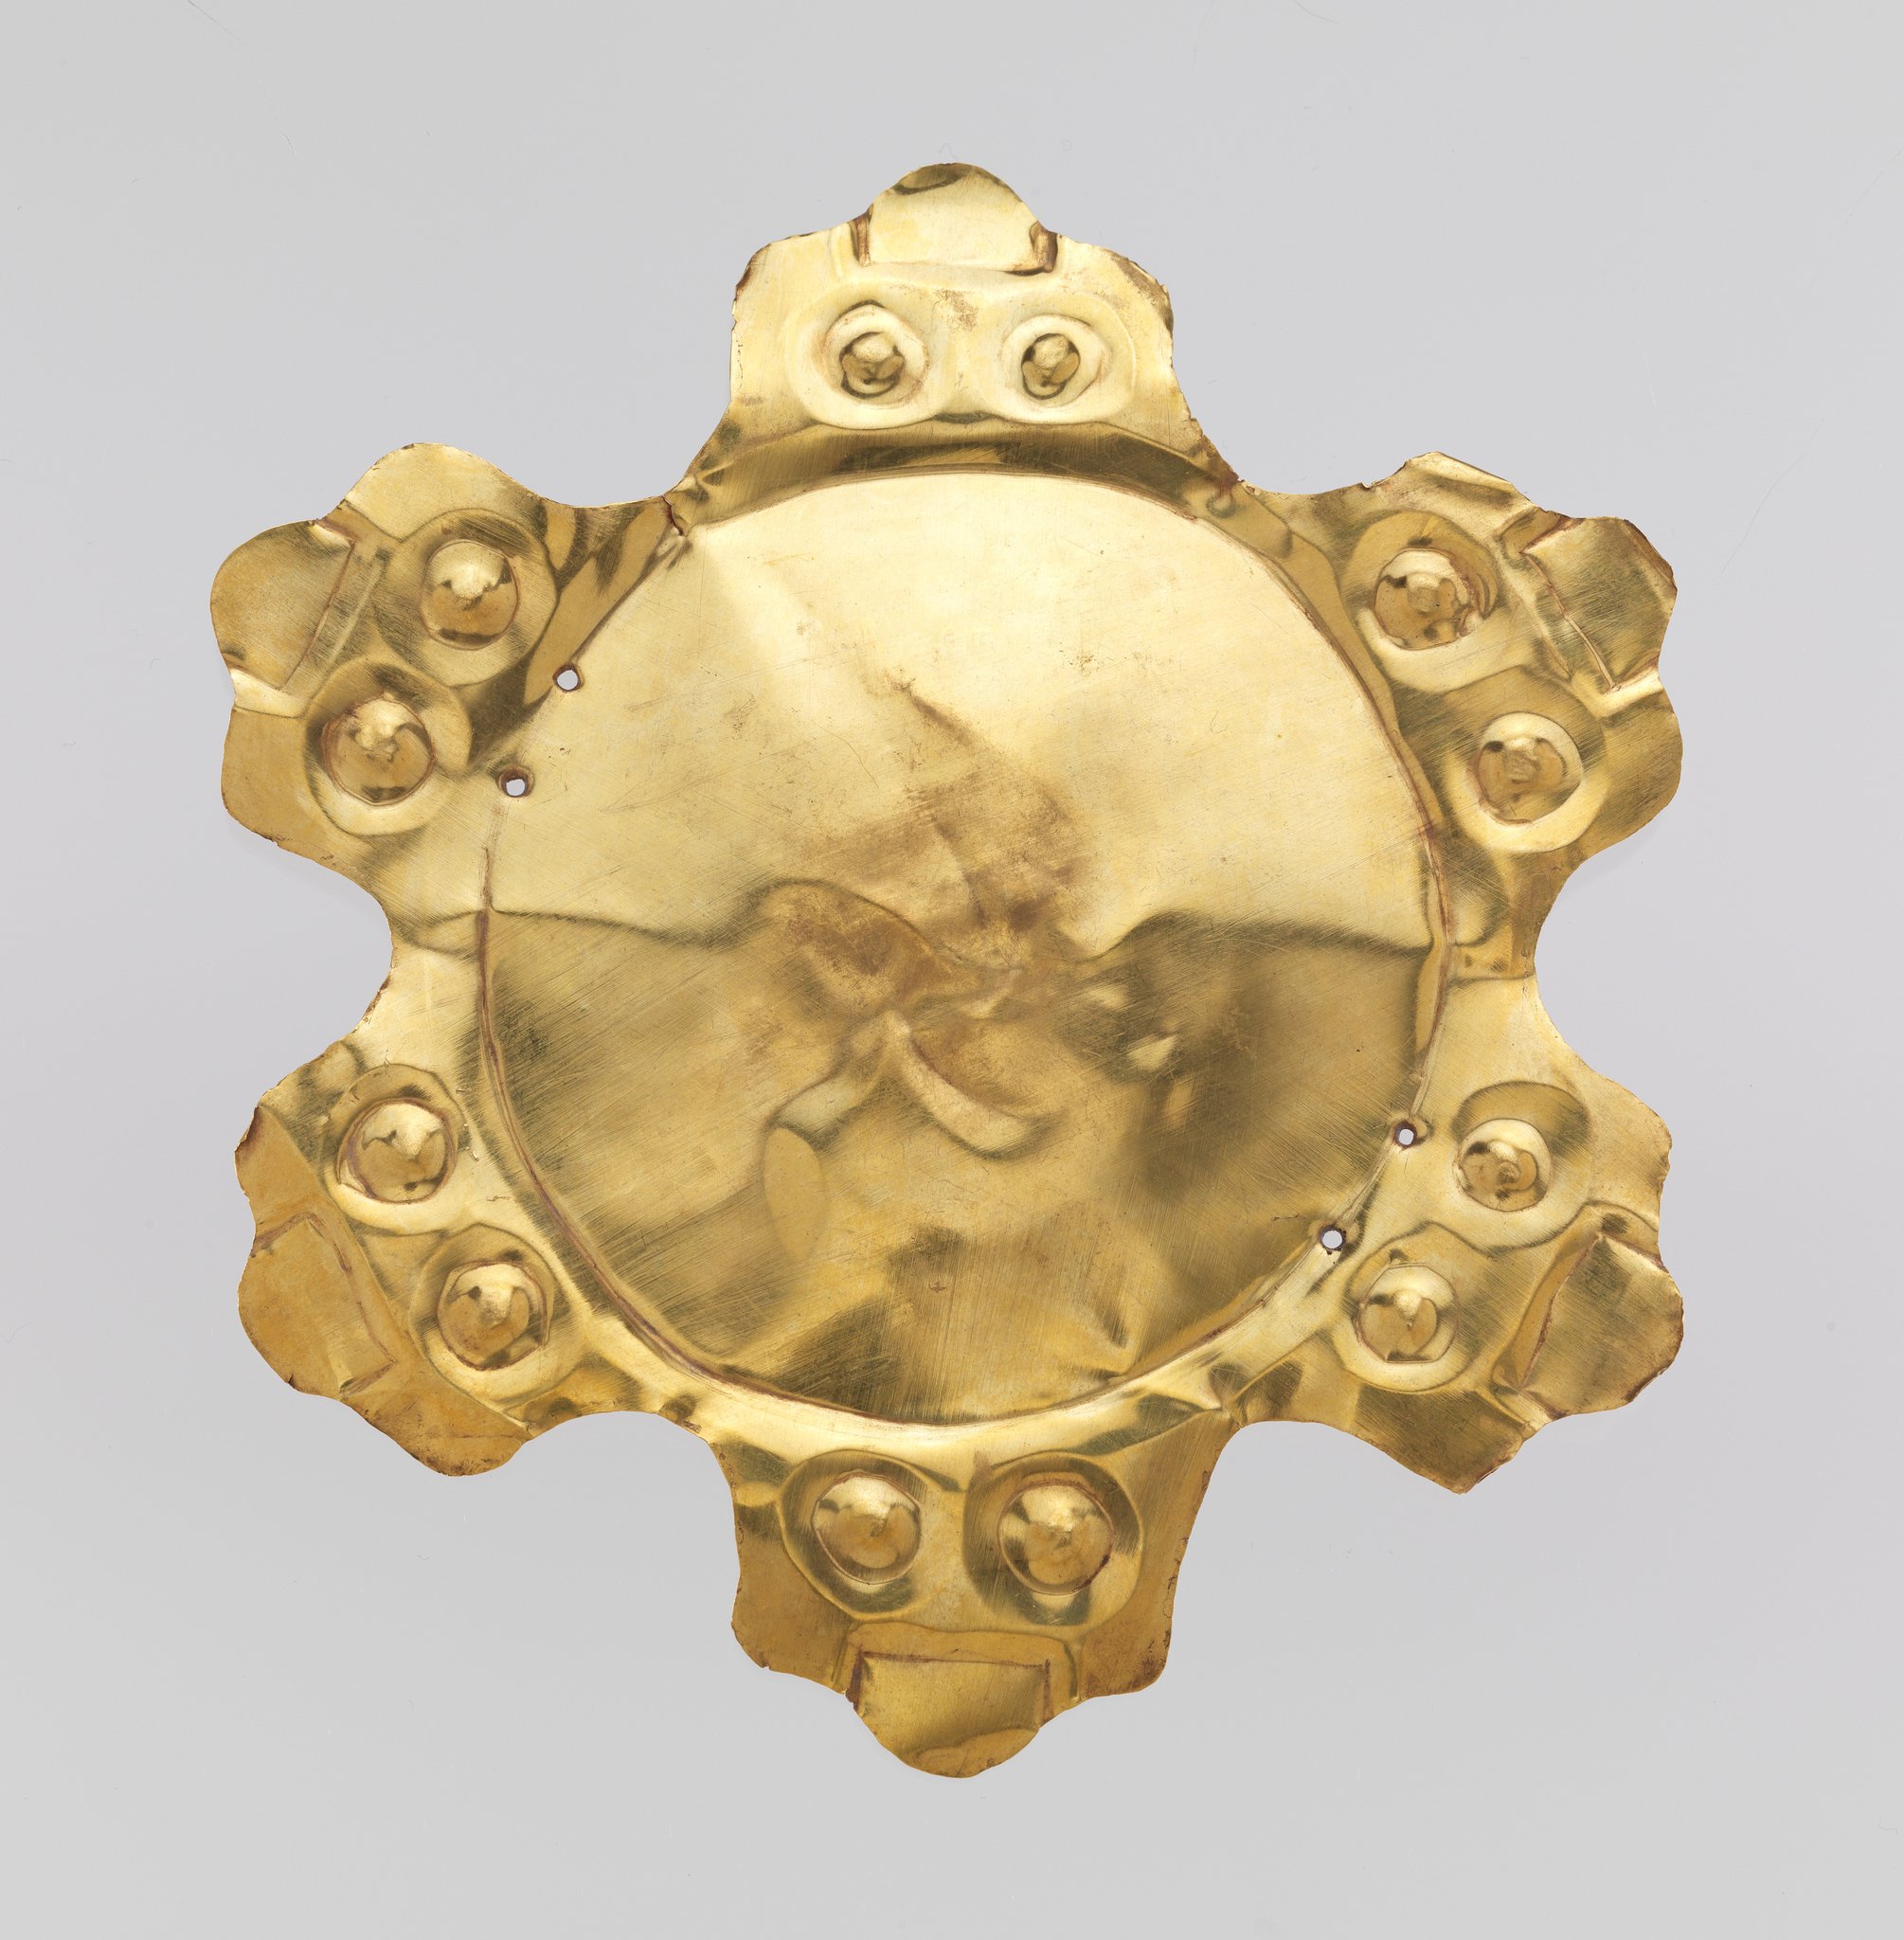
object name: ornament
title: Textile ornament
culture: nasca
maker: nasca artist(s)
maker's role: artist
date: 1-700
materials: gold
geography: peru